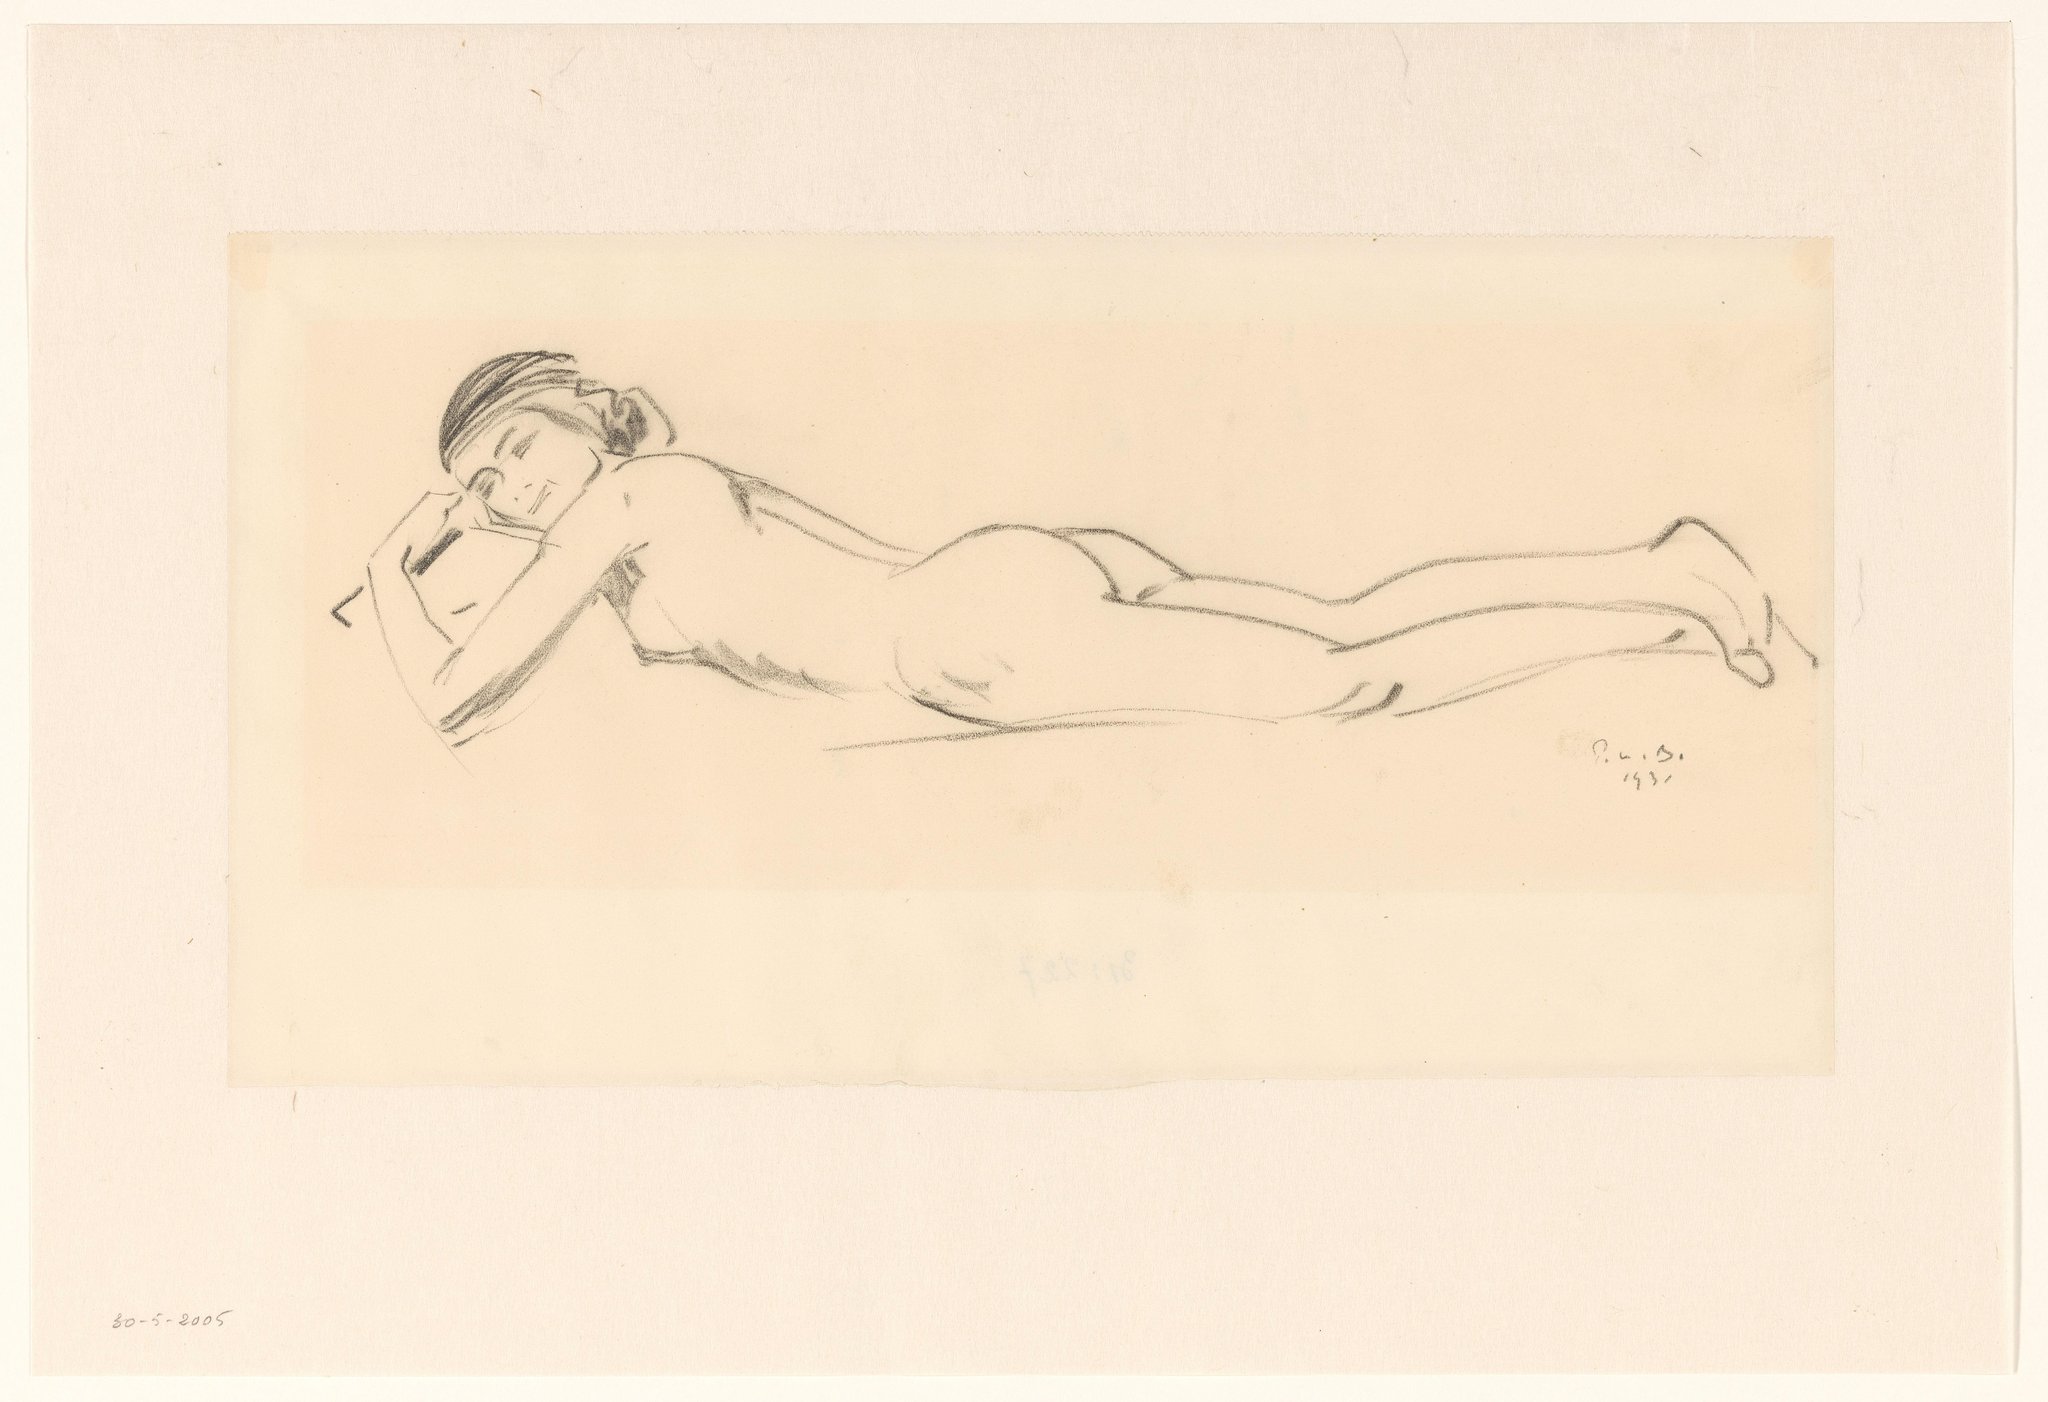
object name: drawing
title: Liggend naakt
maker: pieter willem van baarsel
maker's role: draughtsman, painter, print maker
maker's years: 1879-1949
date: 1931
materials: chalk, paper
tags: lying face downwards - aa - female human figure (+ nude human being)